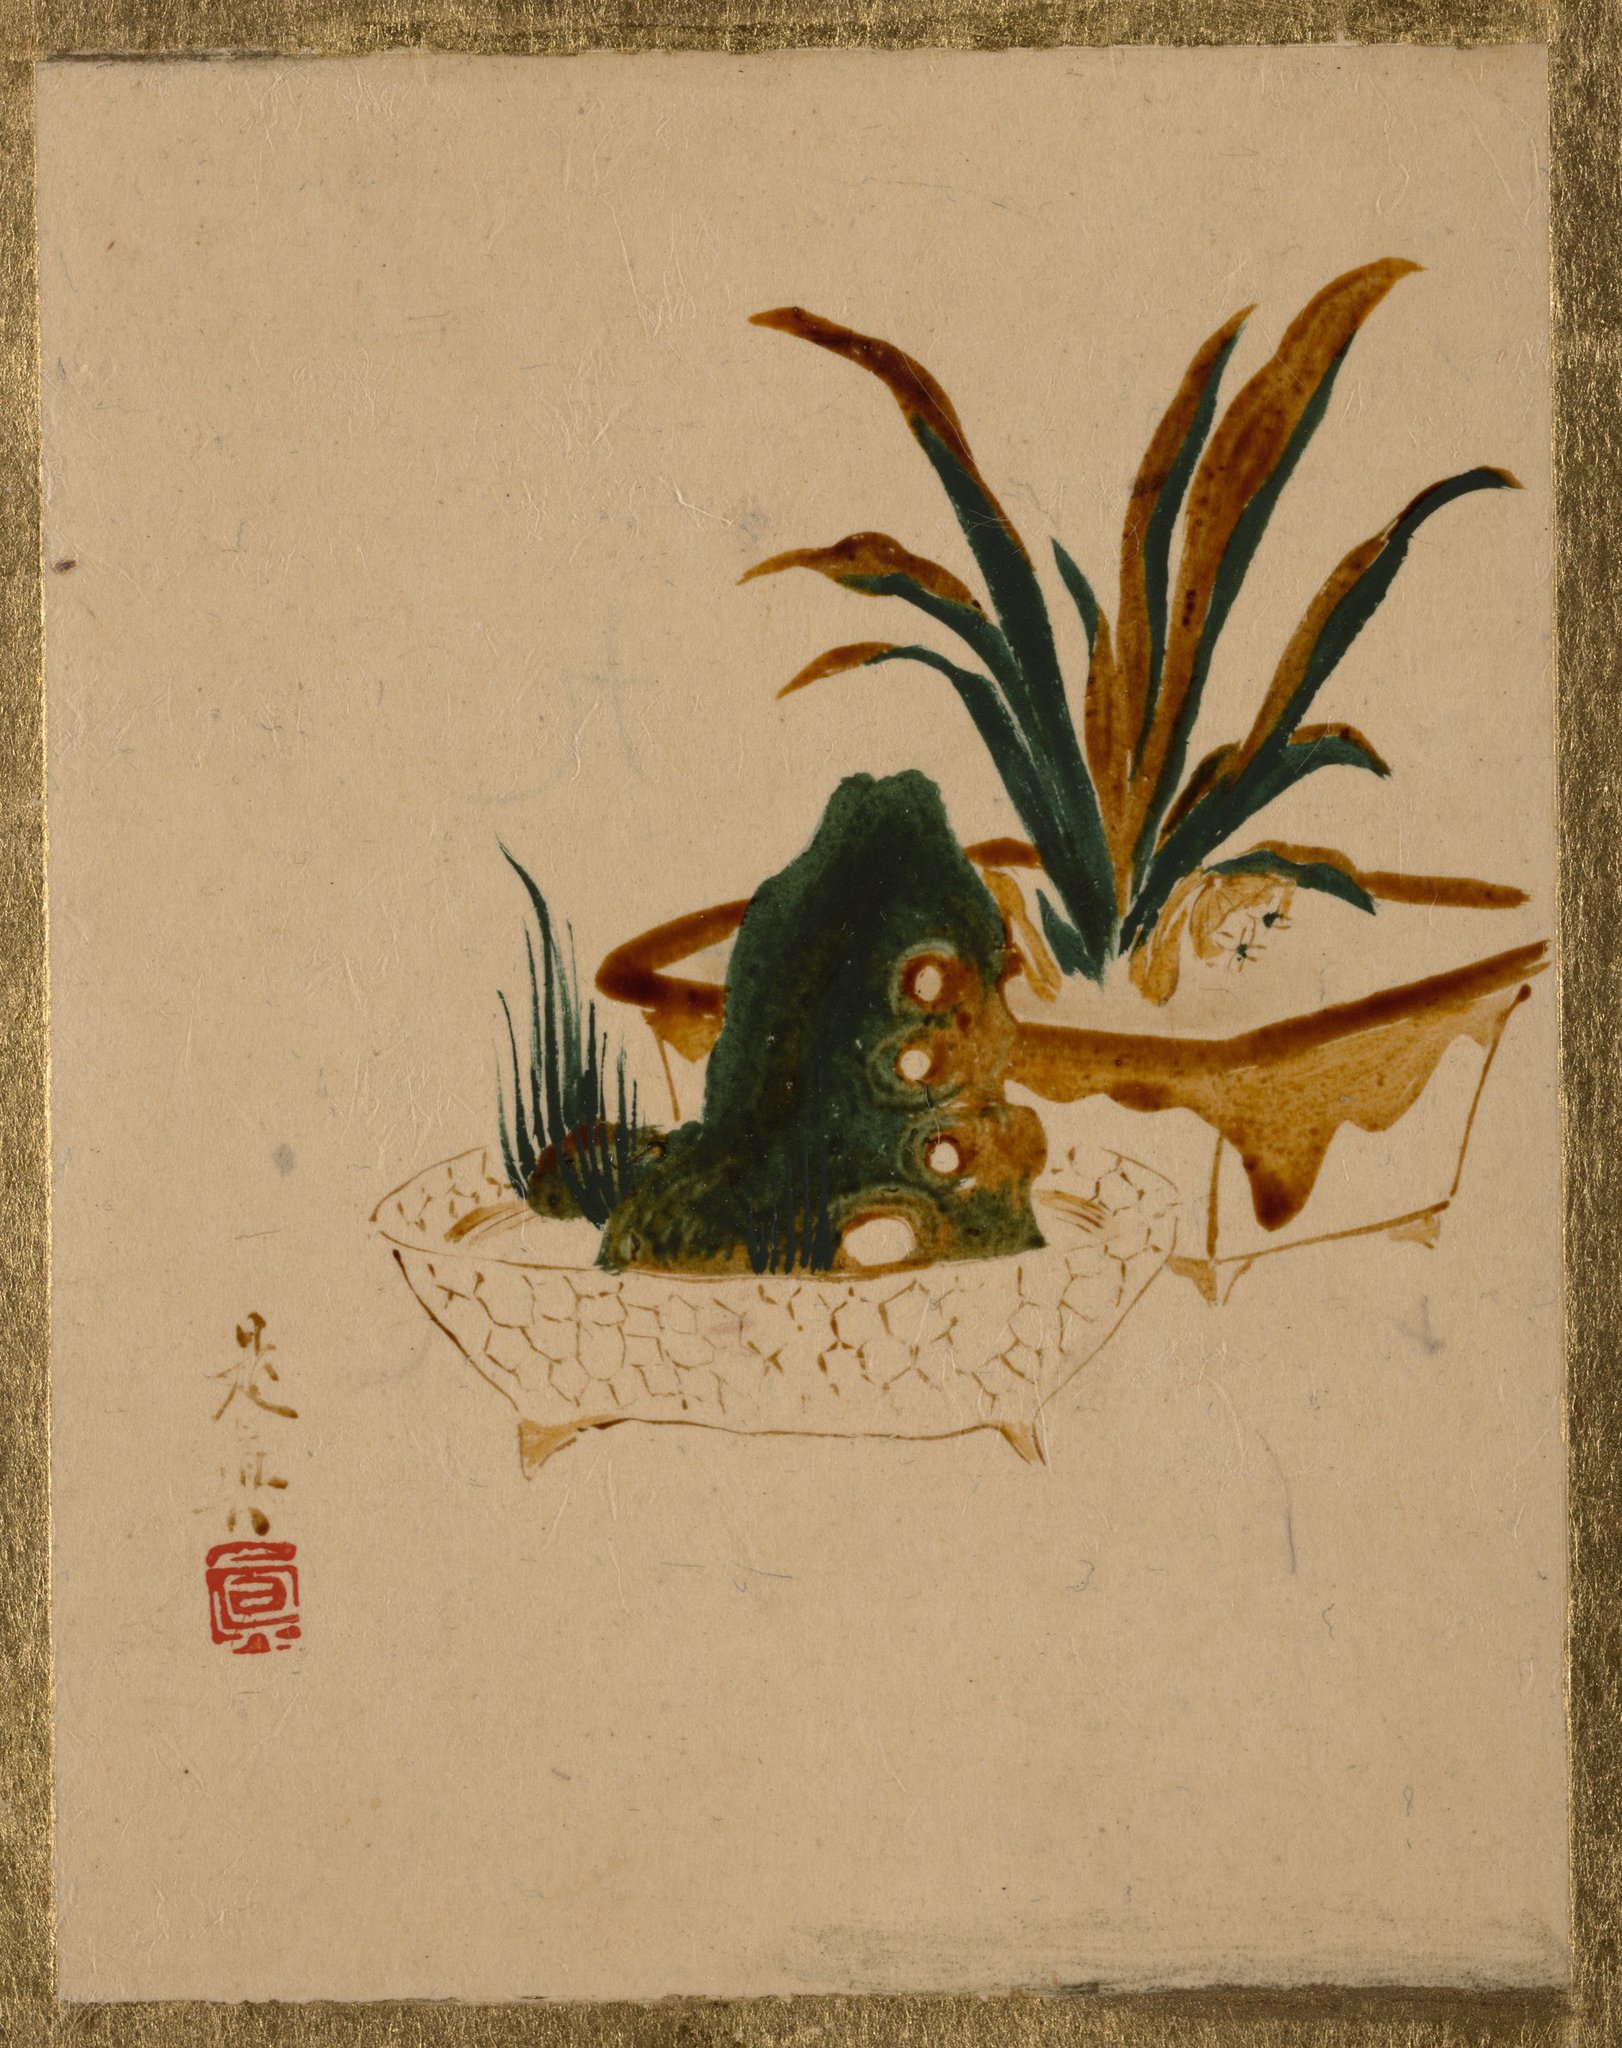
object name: album leaf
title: Flowers in Jardenierres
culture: japanese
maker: shibata zeshin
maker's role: artist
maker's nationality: japanese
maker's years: 1807-1891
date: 1807-1868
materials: lacquer, paper